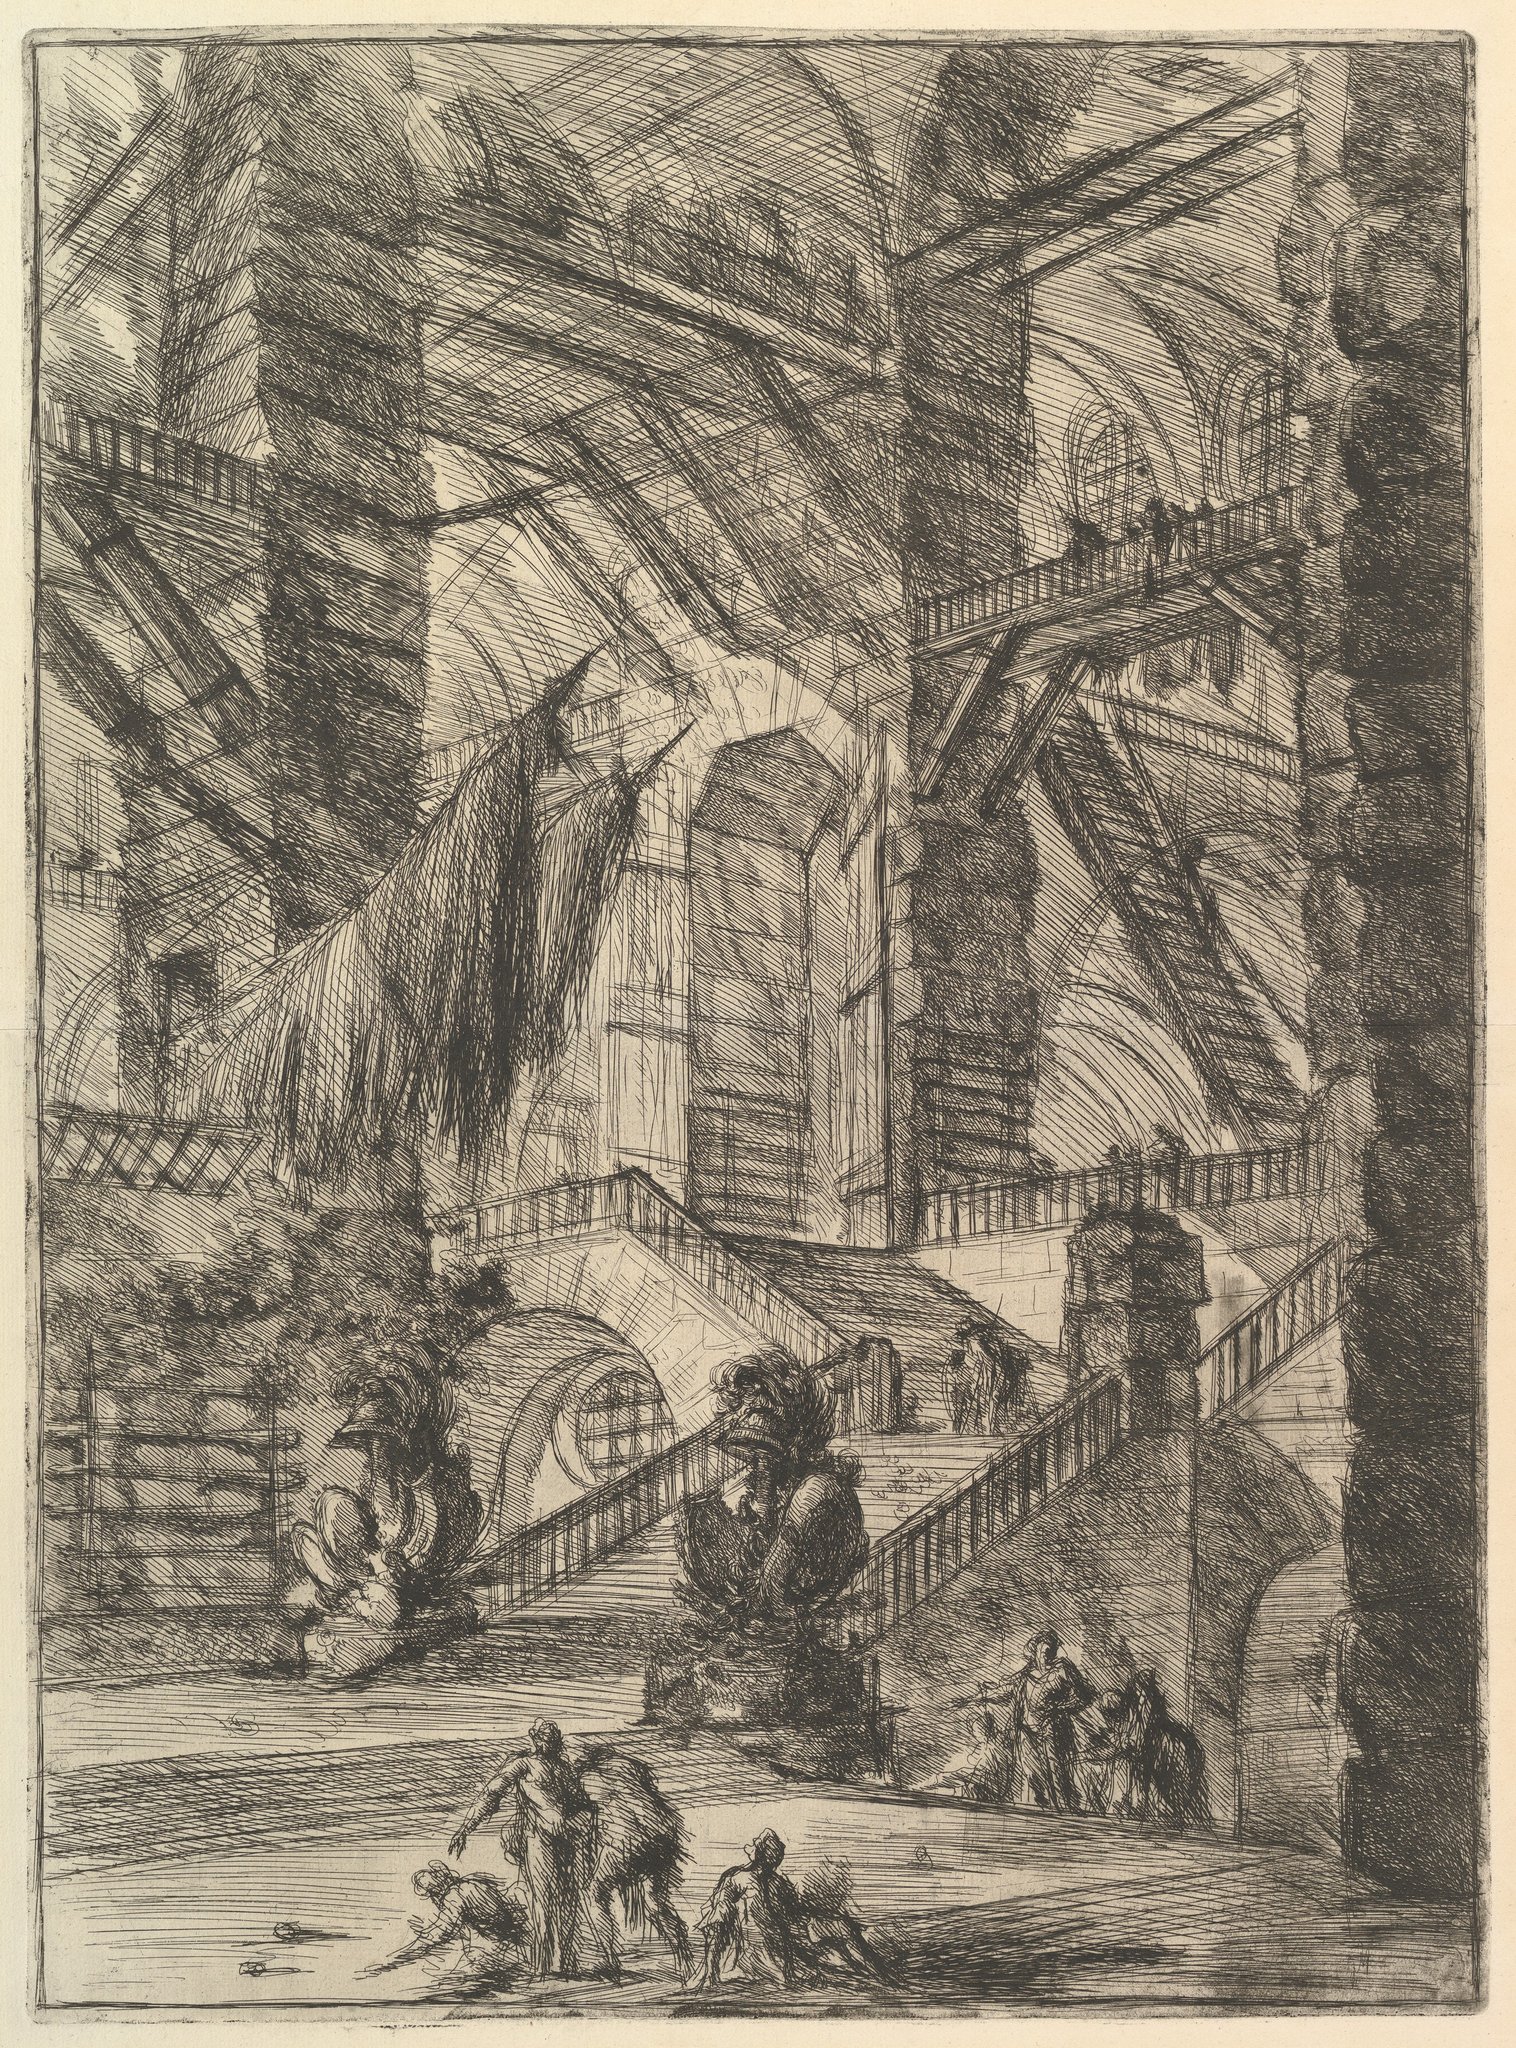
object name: print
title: The Staircase with Trophies, from "Carceri d'invenzione" (Imaginary Prisons)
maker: giovanni battista piranesi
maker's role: artist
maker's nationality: italian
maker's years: 1720-1778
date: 1749-1750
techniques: engraving, etching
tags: prisons,stairs